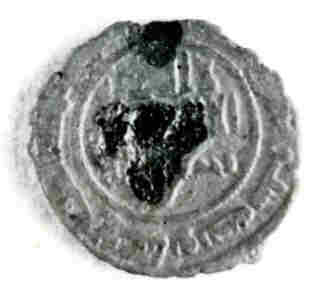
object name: coin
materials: copper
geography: iran